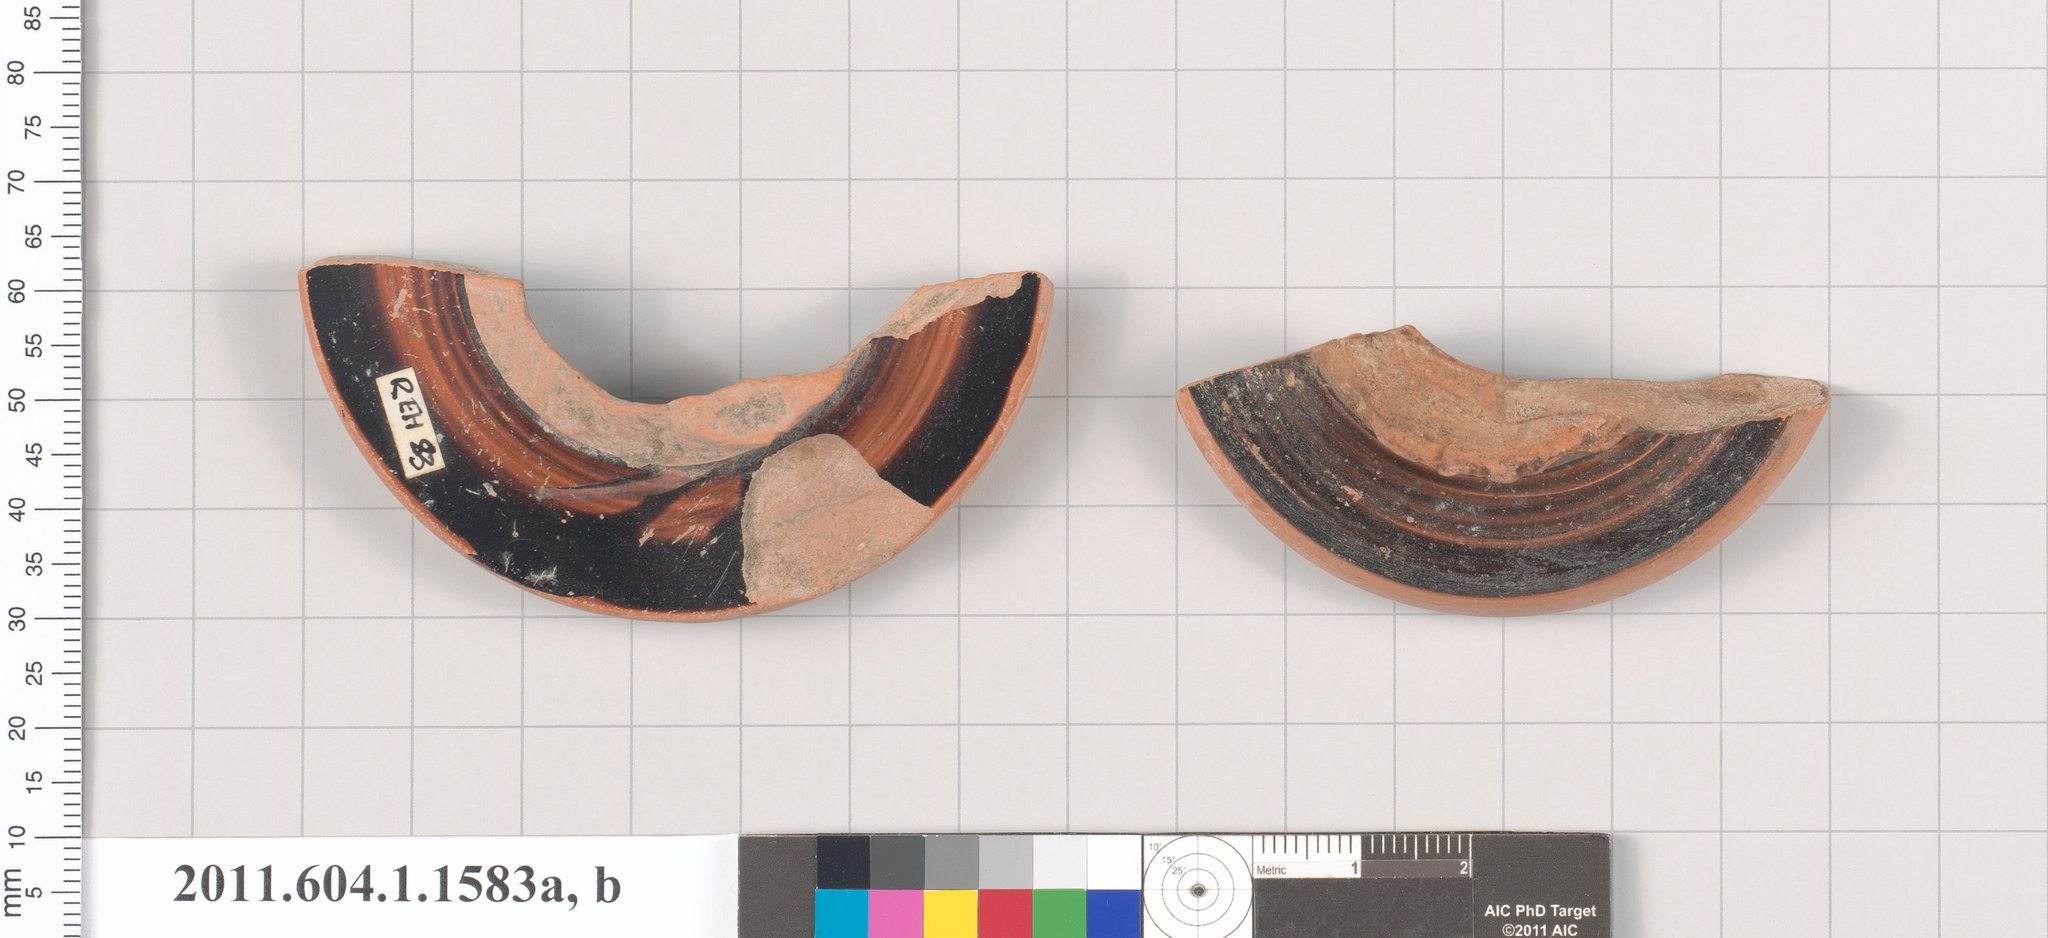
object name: kylix fragment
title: Terracotta fragments of kylikes (drinking cups)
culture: greek, attic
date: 500-401 BCE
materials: terracotta